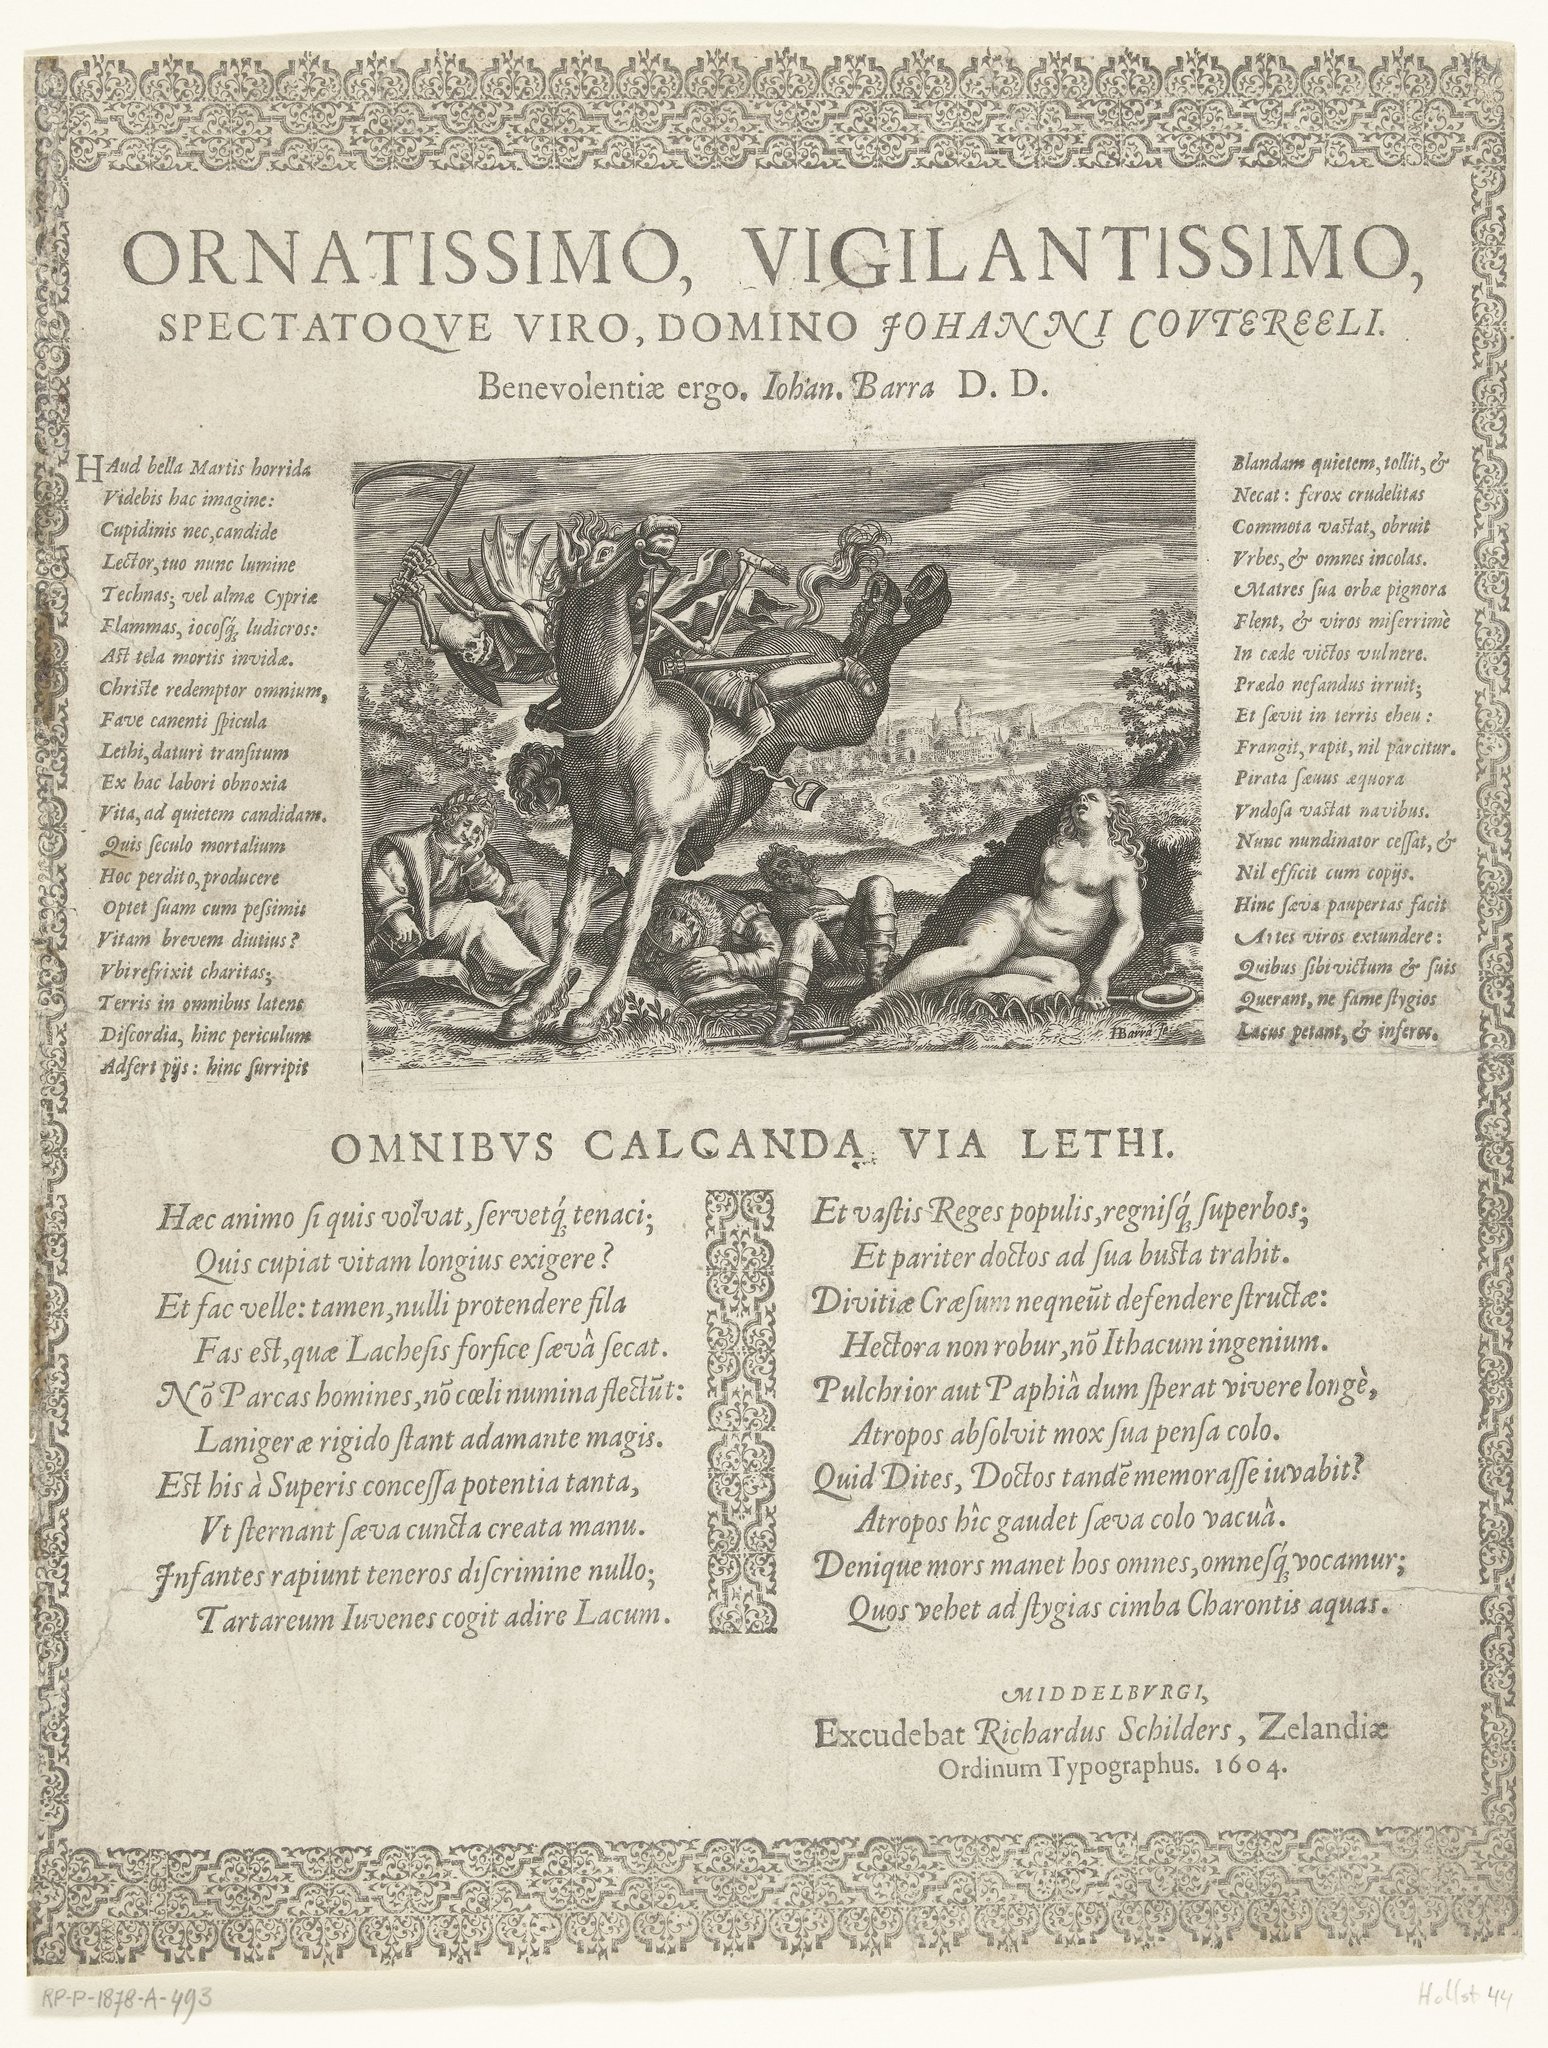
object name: print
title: Ornatissimo Vigilantissimo spectatoque viro domino Johanni Covtereeli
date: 1604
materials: paper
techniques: engraving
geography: middelburg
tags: antwerp, johan coutereels, scholar, philosopher, mirror, death battling with life, or with the living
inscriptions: collector's mark: Lugt 2228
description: Oorkonde voor Johan Coutereels met de dood zittend op een steigerend paard, Het skelet met vleugels valt een dichter met lauwerkrans aan. Een koning en een boer zijn al gedood. Een naakte vrouw met een spiegel in de hand ligt op de grond. Links, rechts en onder de voorstelling staan Latijnse versen en het geheel heeft een rechthoekige omlijsting van fijne ornamenten.